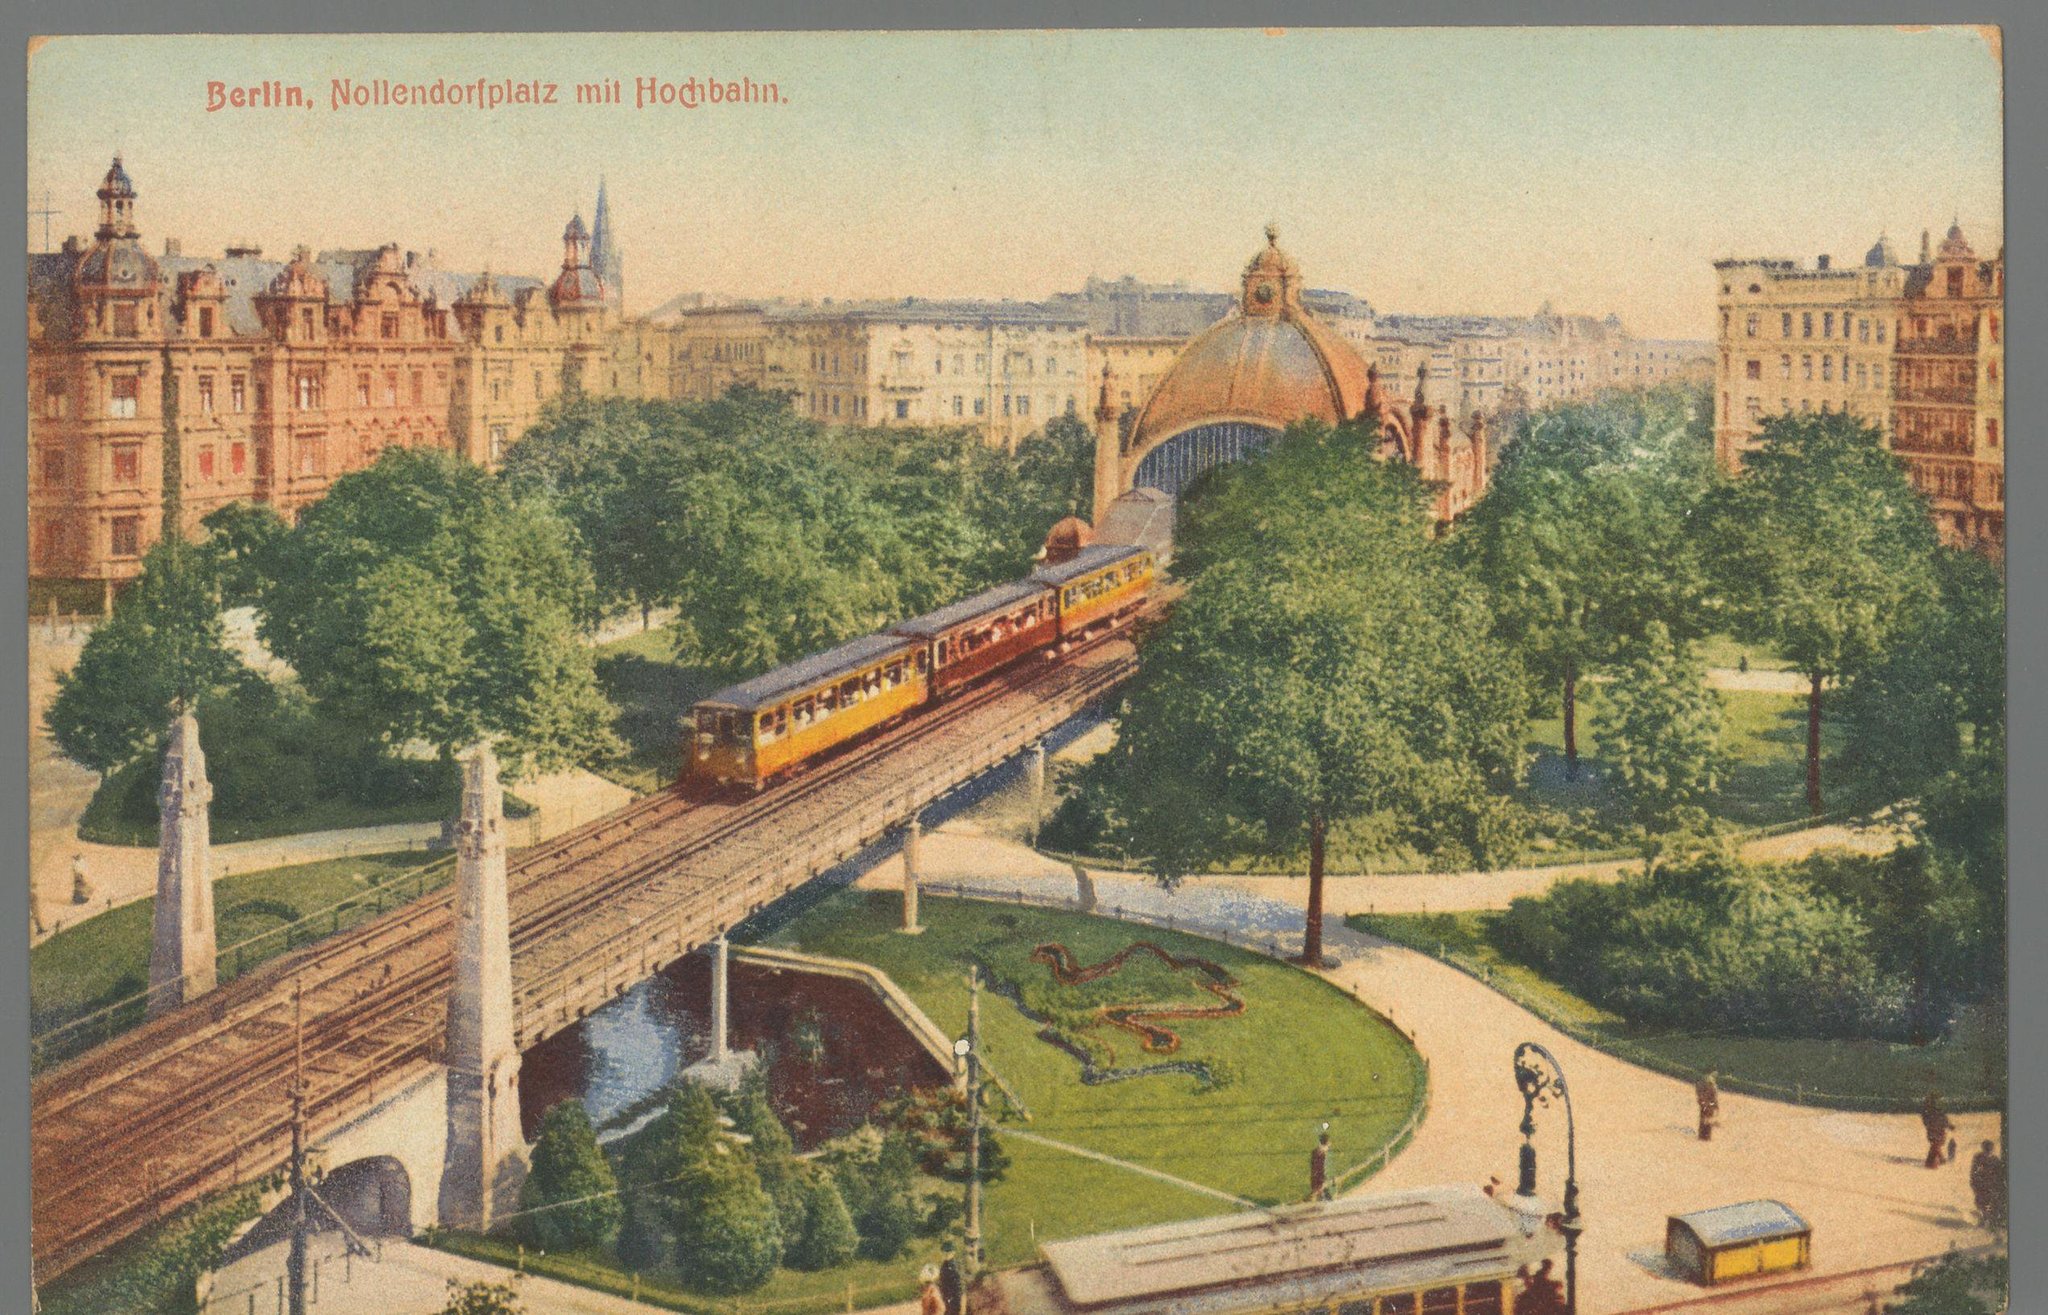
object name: photomechanical print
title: Berlin, Nollendorfplatz mit Hochbahn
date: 1905-1909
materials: cardboard, photographic process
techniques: writing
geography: berlin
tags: square, place, circus, etc., city-view, and landscape with man-made constructions, railway, train, station; shelter (railway, tramway)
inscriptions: monogram: ‘A.S.B.’